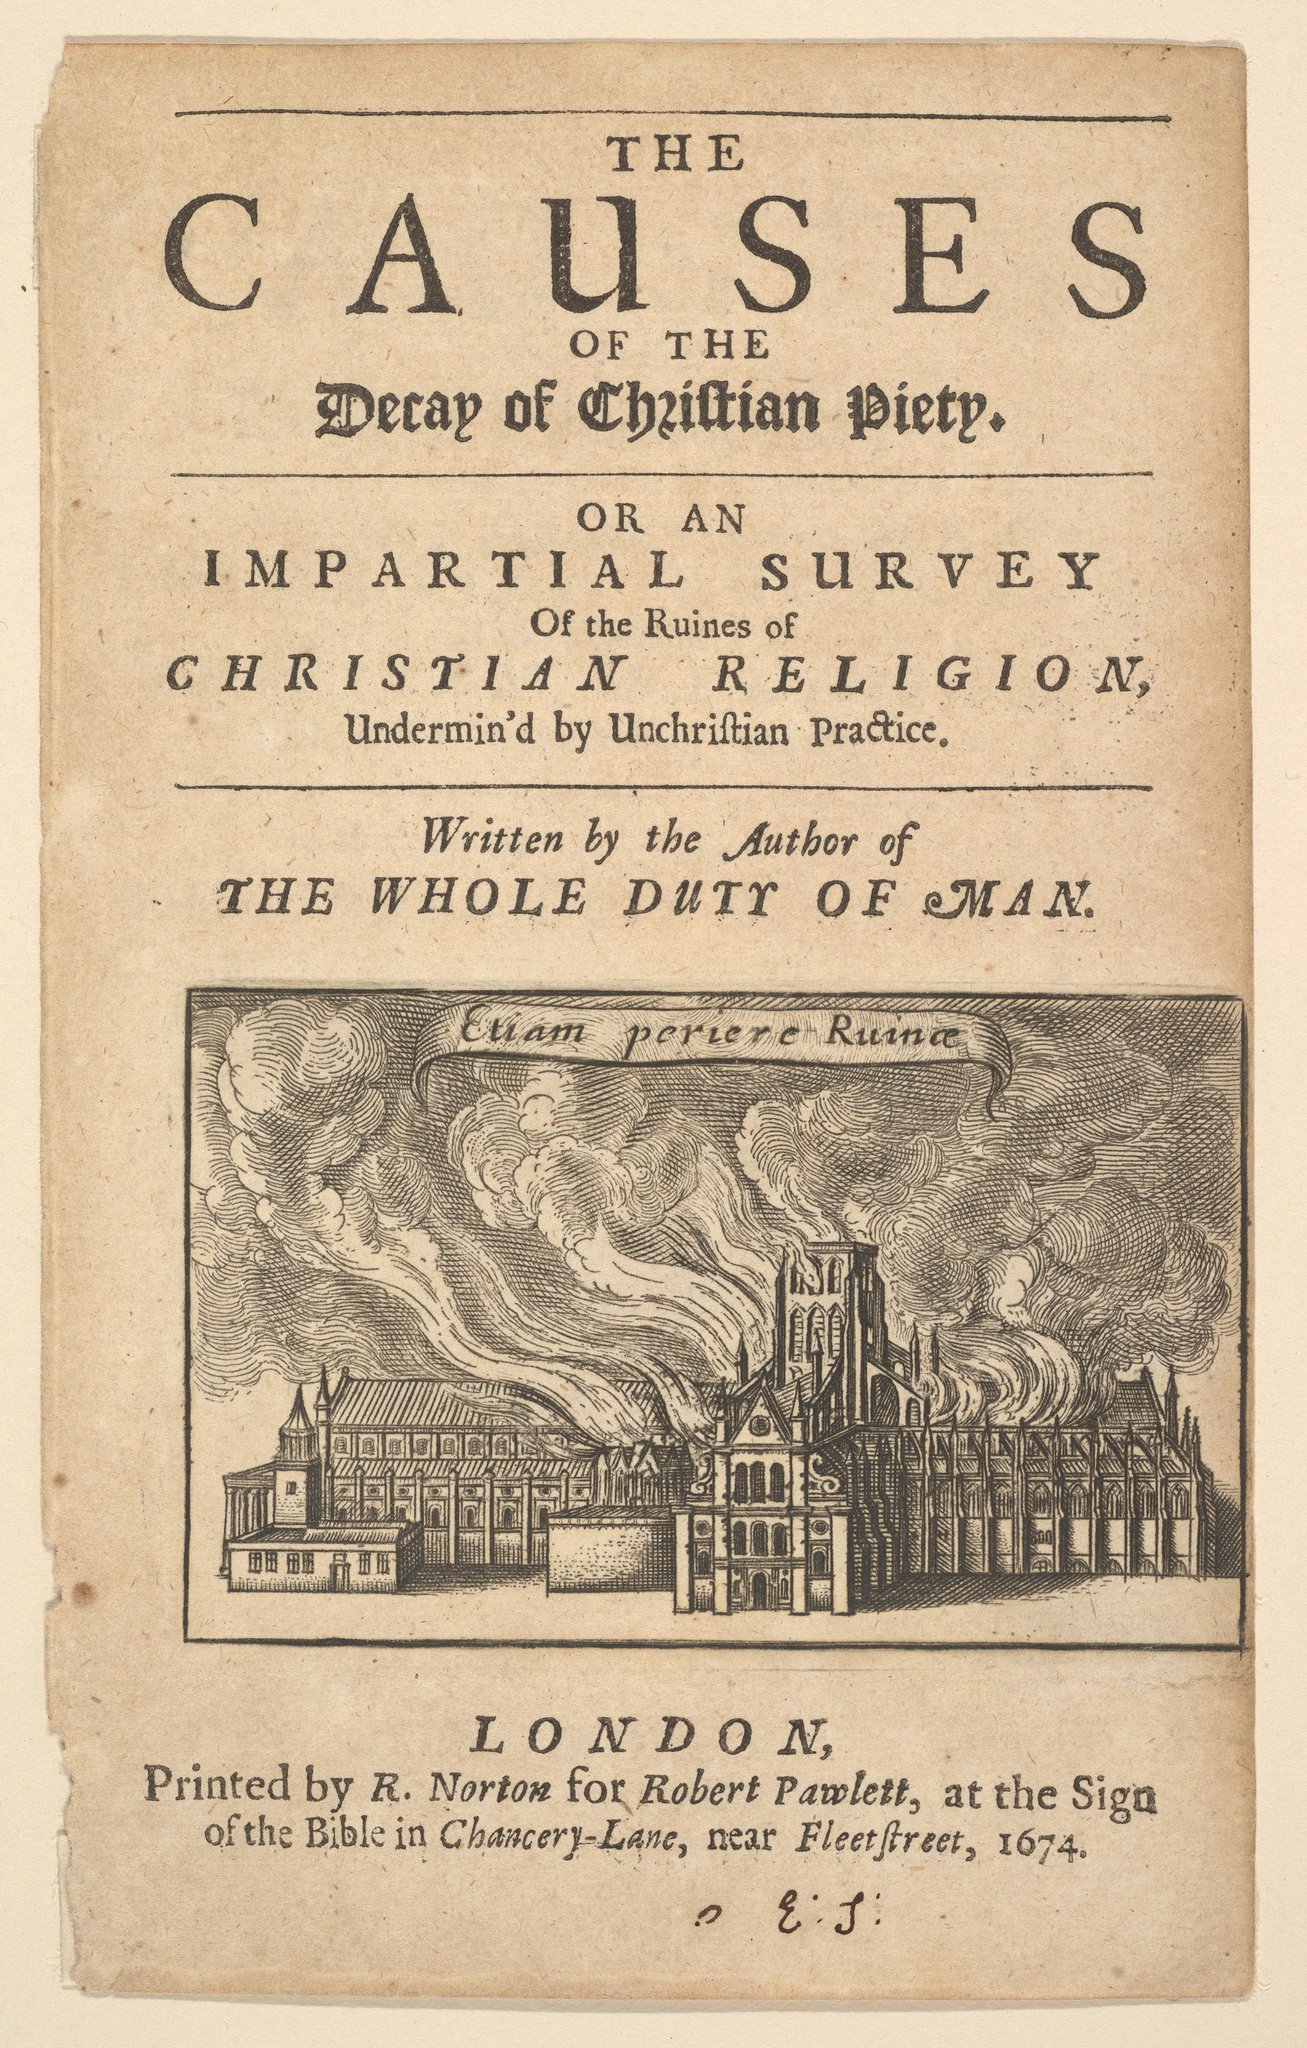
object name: print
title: Title Page: The Causes of Decay of Christian Piety, with vignette of St. Paul's Burning, (Lex ignea)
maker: wenceslaus hollar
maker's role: artist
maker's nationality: bohemian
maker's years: 1607-1677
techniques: etching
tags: buildings,churches,fire